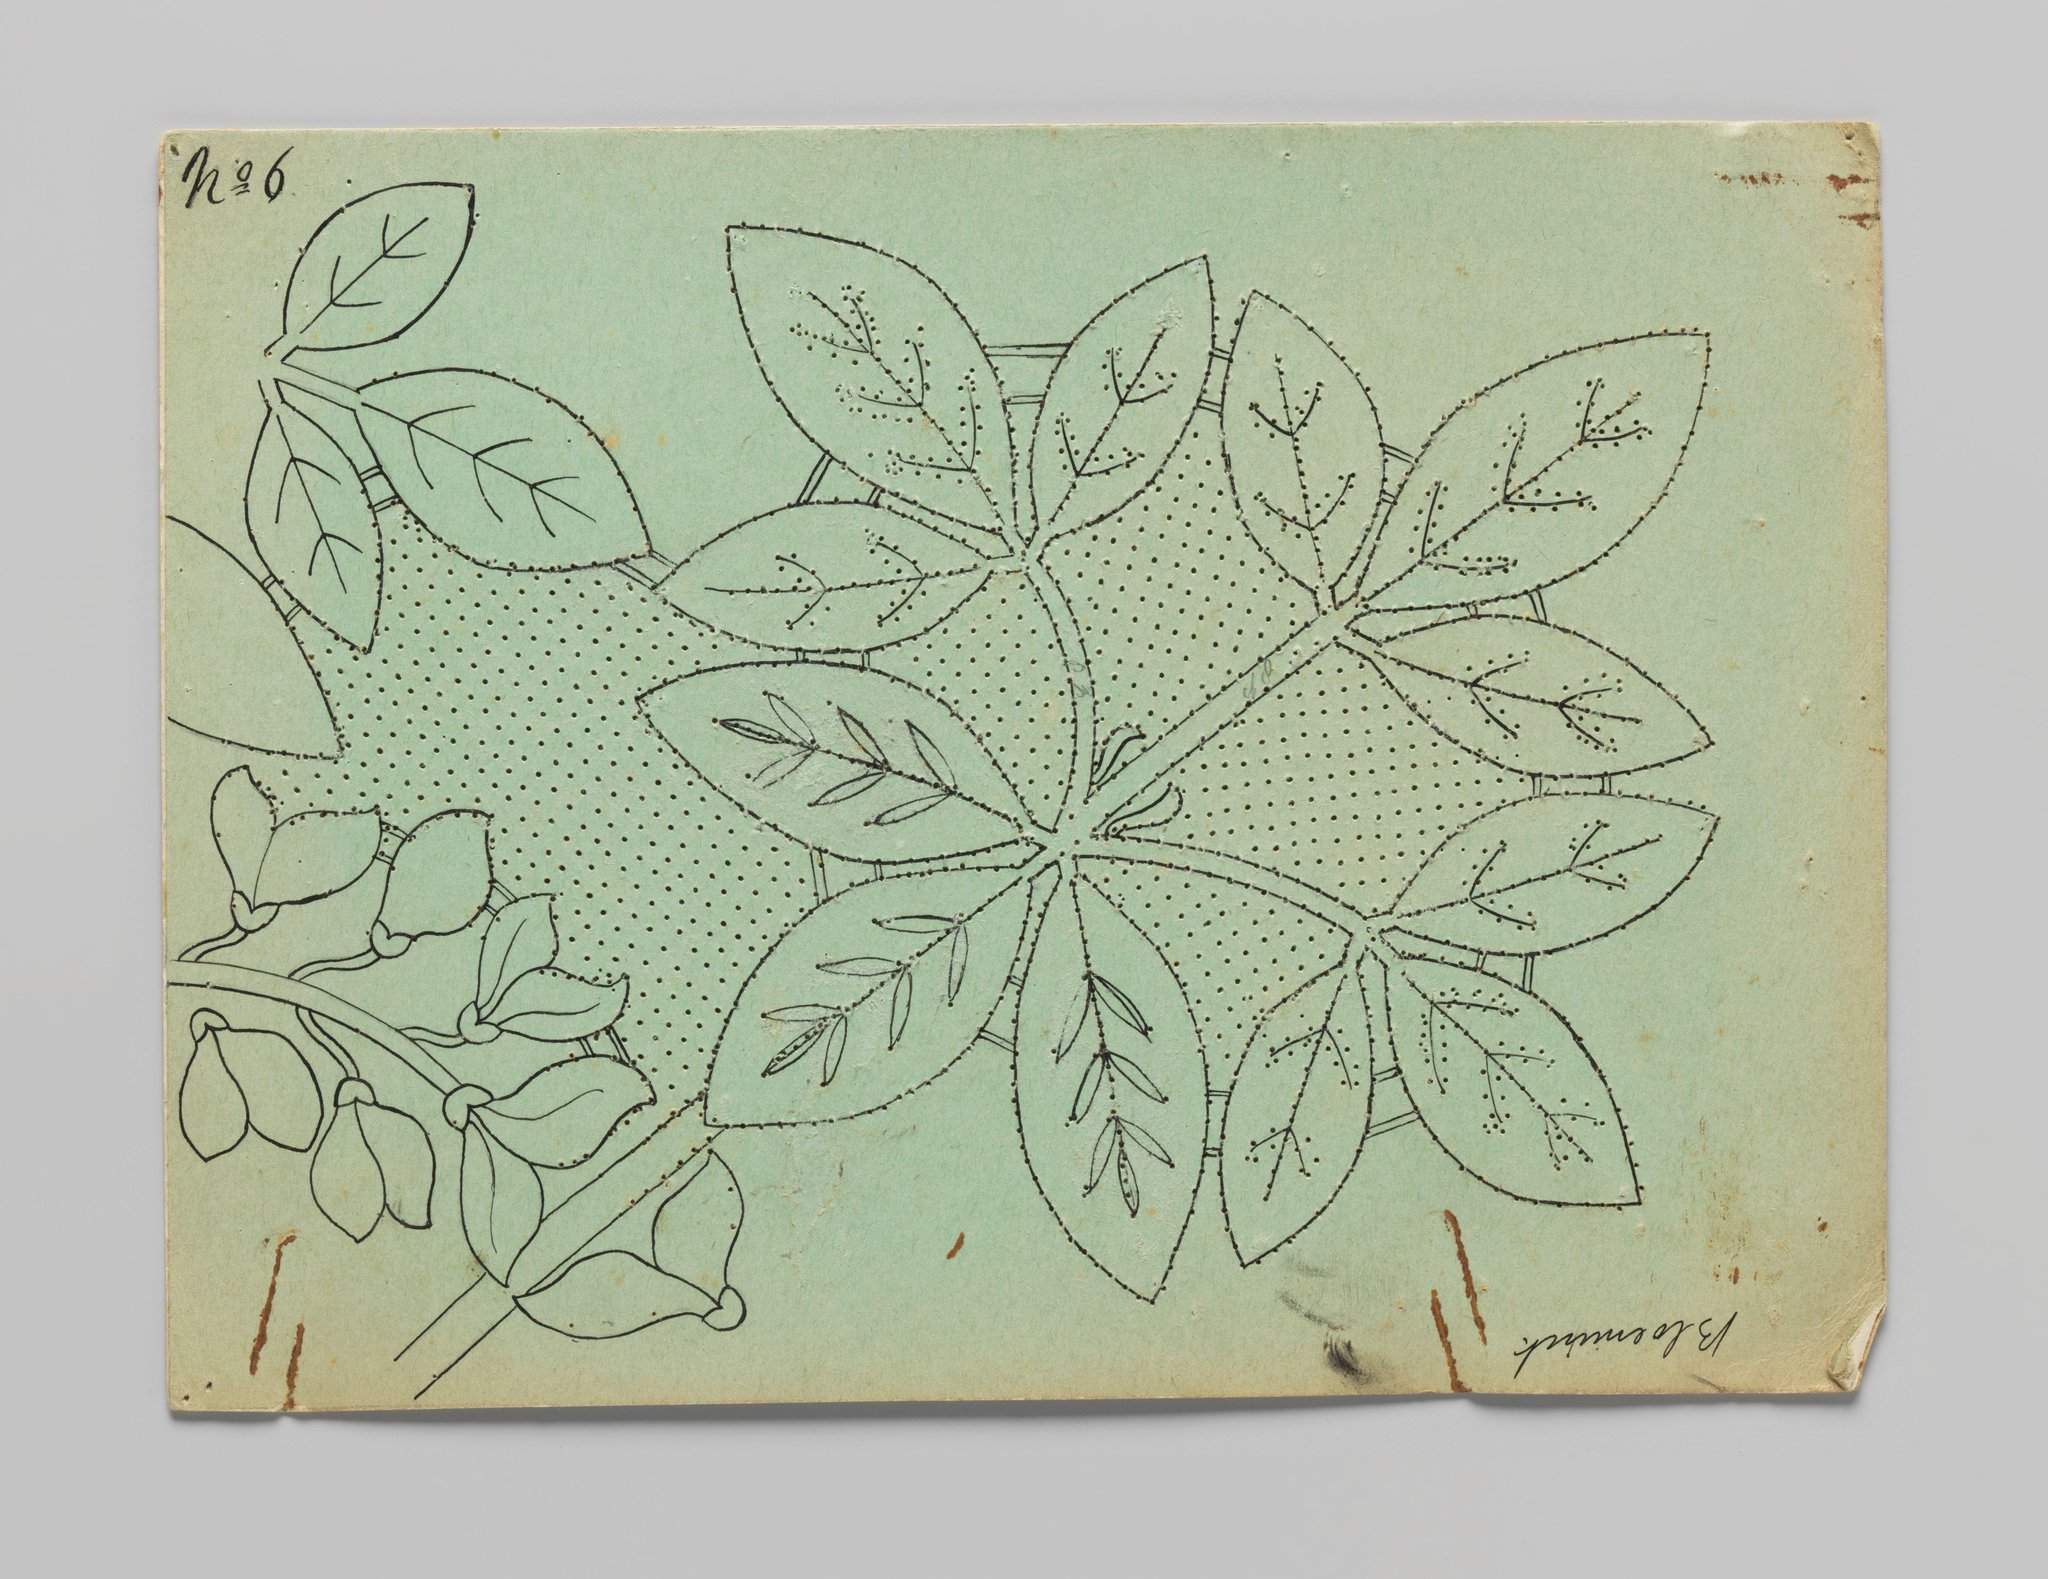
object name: lace pattern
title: Kantpatroon voor een kleed van kloskant met goudenregentakken en -bloemen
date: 1912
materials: paper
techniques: drawing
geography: apeldoorn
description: Kantbrief of kantpatroon met een deel van het patroon voor een kleed met invnr. BK-1979-84. De brief is genummerd (6) en op de voorkant is de naam Bloemink geschreven.